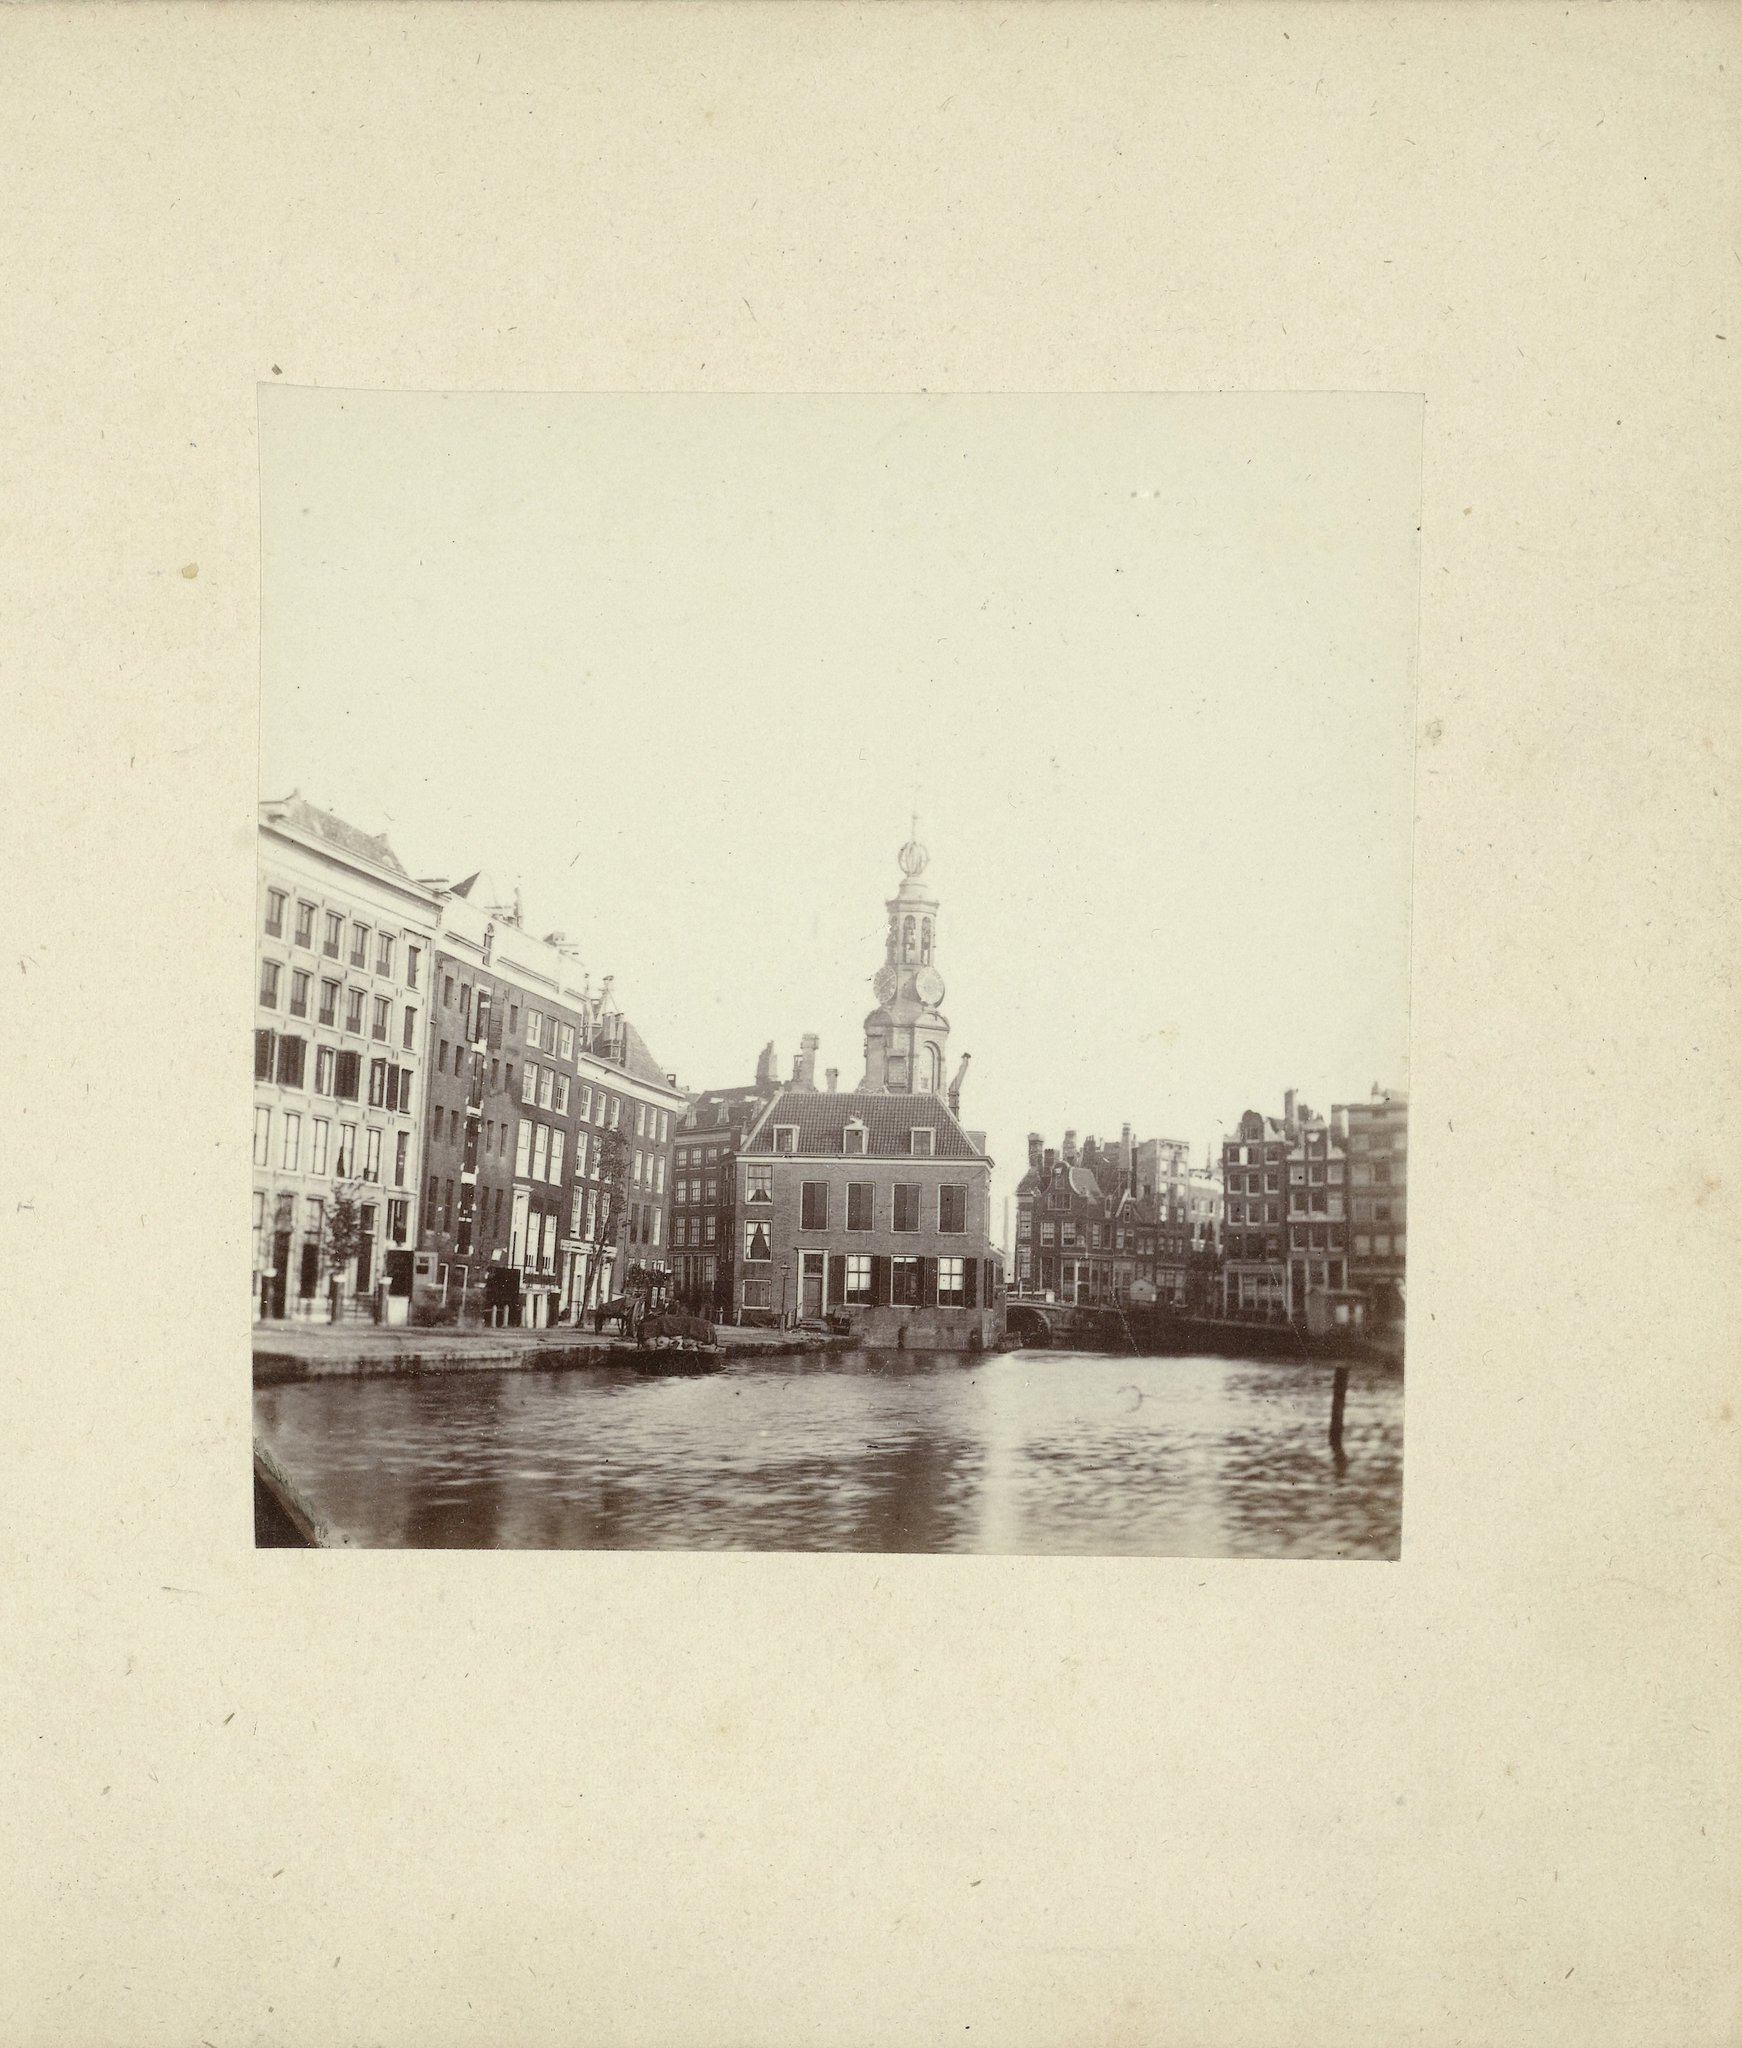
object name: photograph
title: Singel gezien naar de Munttoren in Amsterdam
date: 1860-1875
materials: cardboard, paper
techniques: albumen print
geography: amsterdam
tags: tower, clock tower ~ monumental adornment, canals, waters (in city)